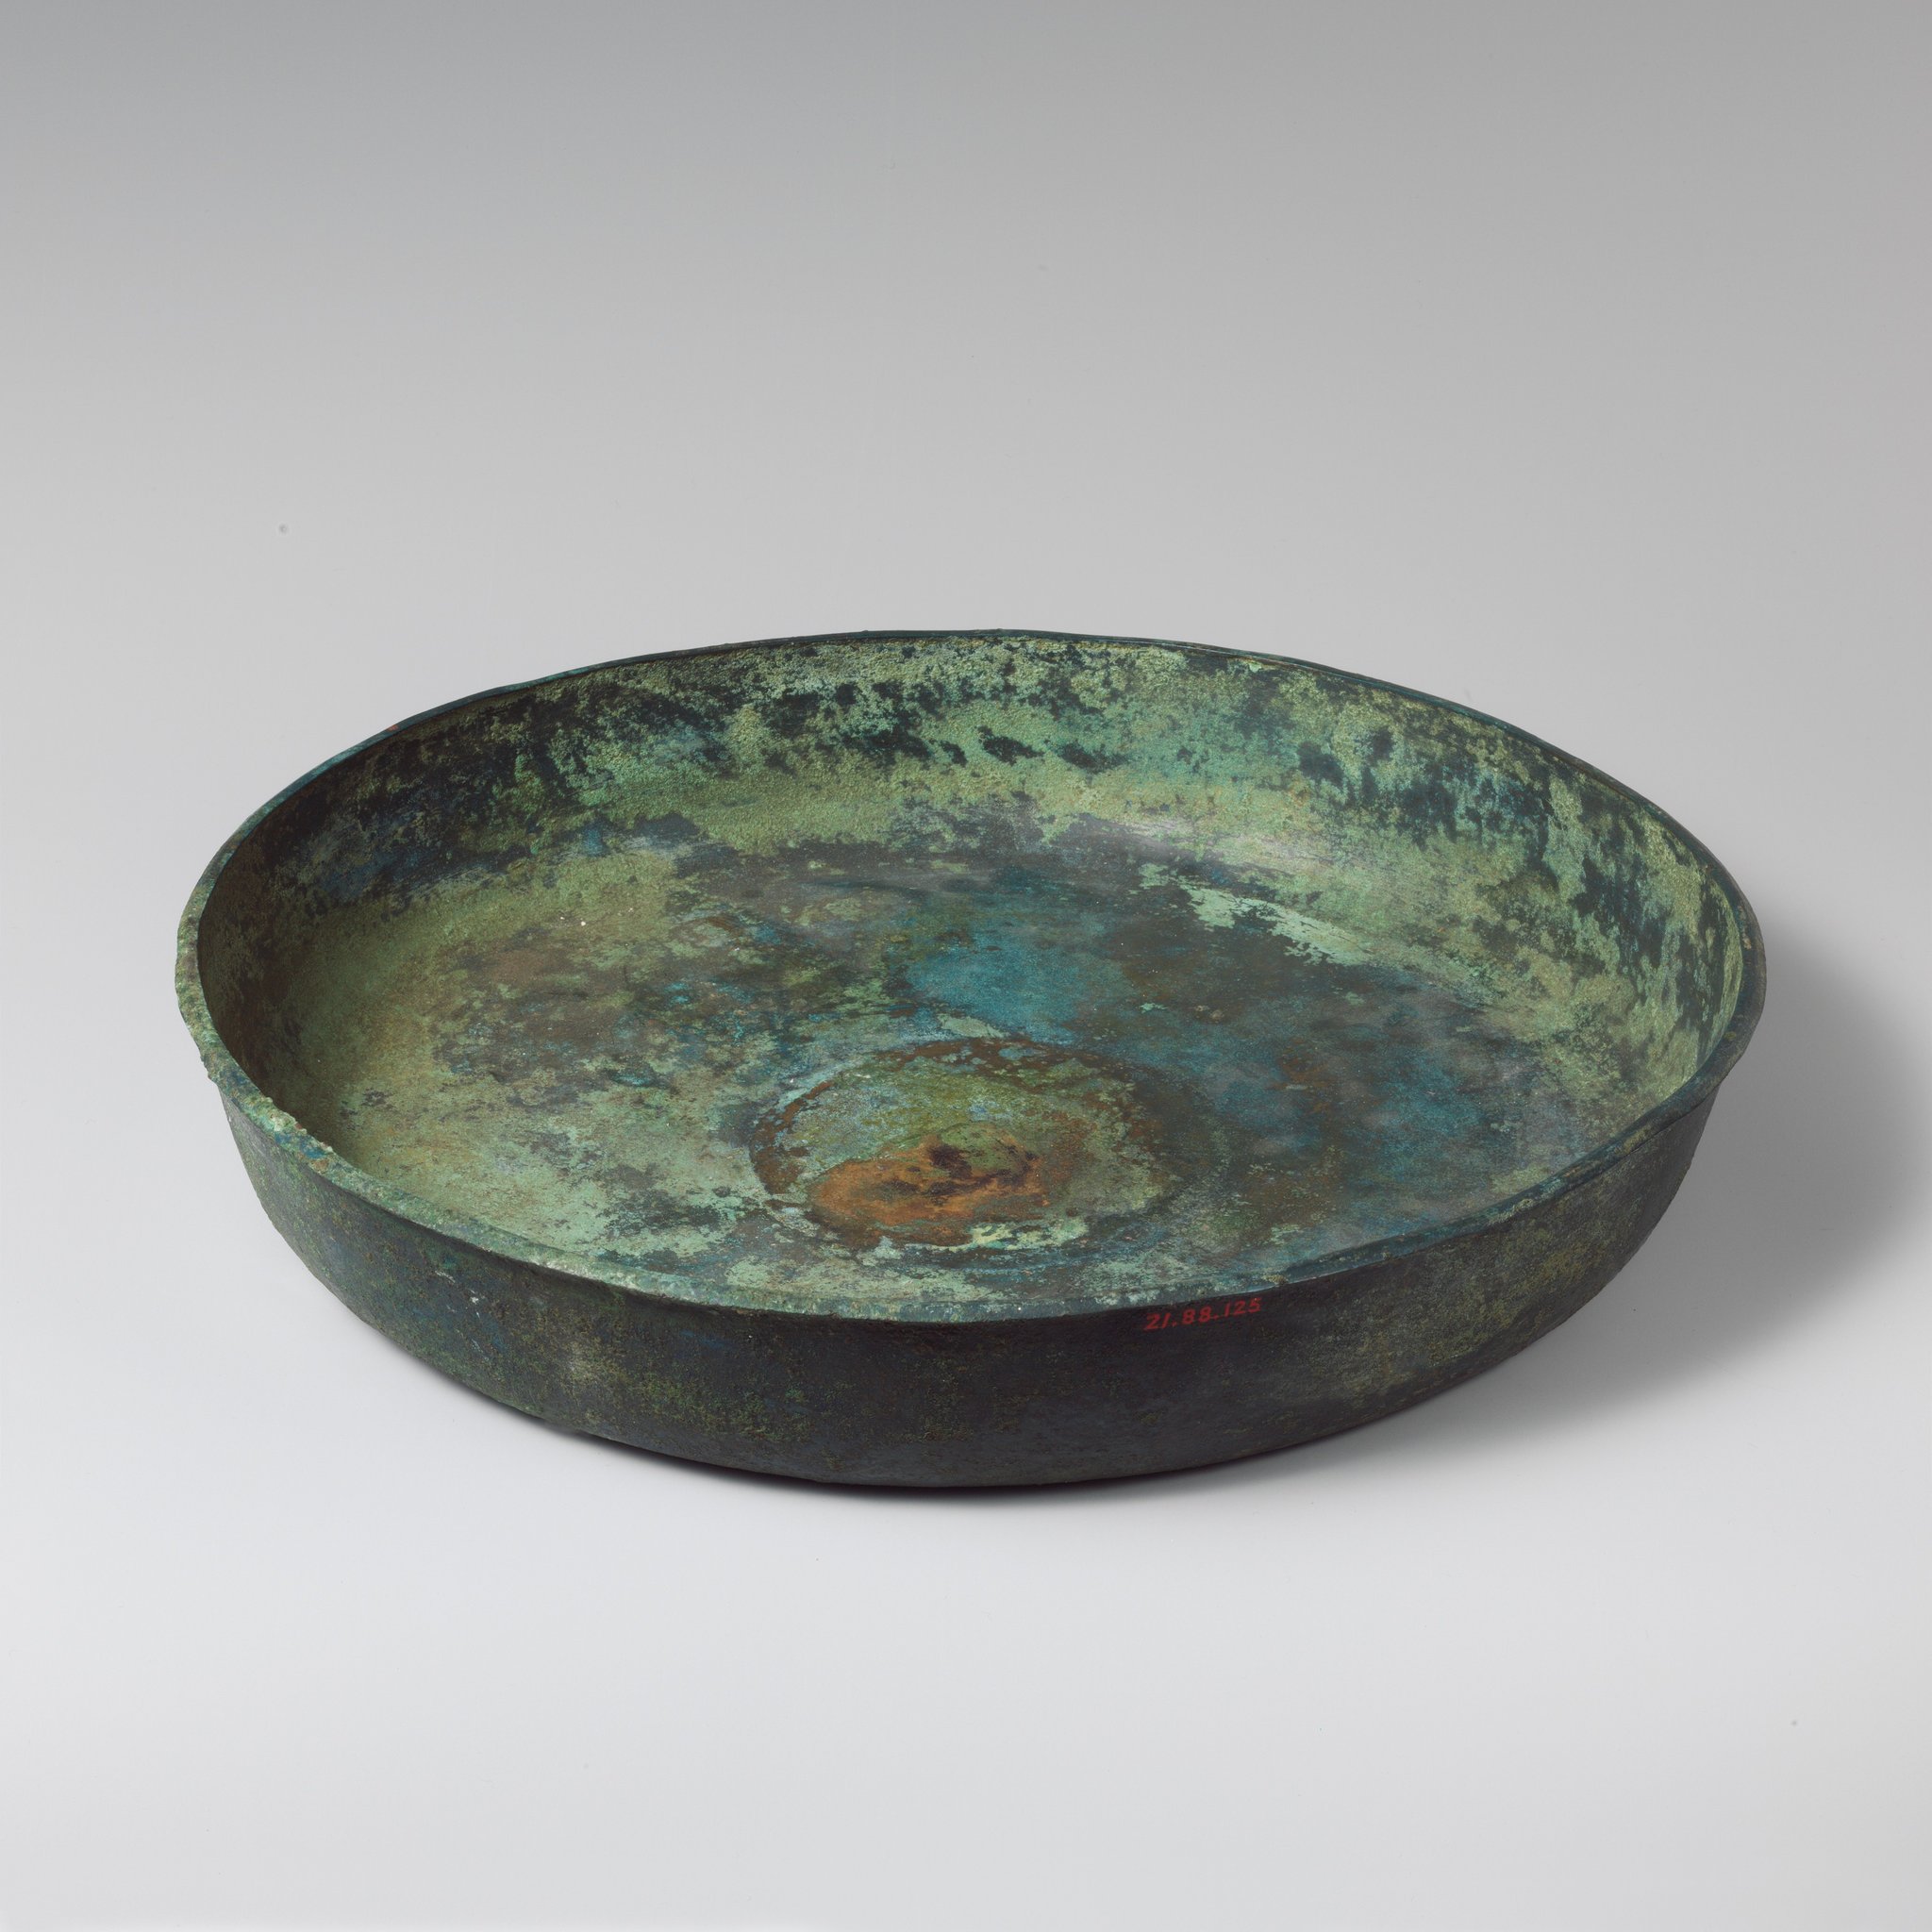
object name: bowl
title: Bronze bowl and oinochoe (jug)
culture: etruscan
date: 534-468 BCE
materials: bronze